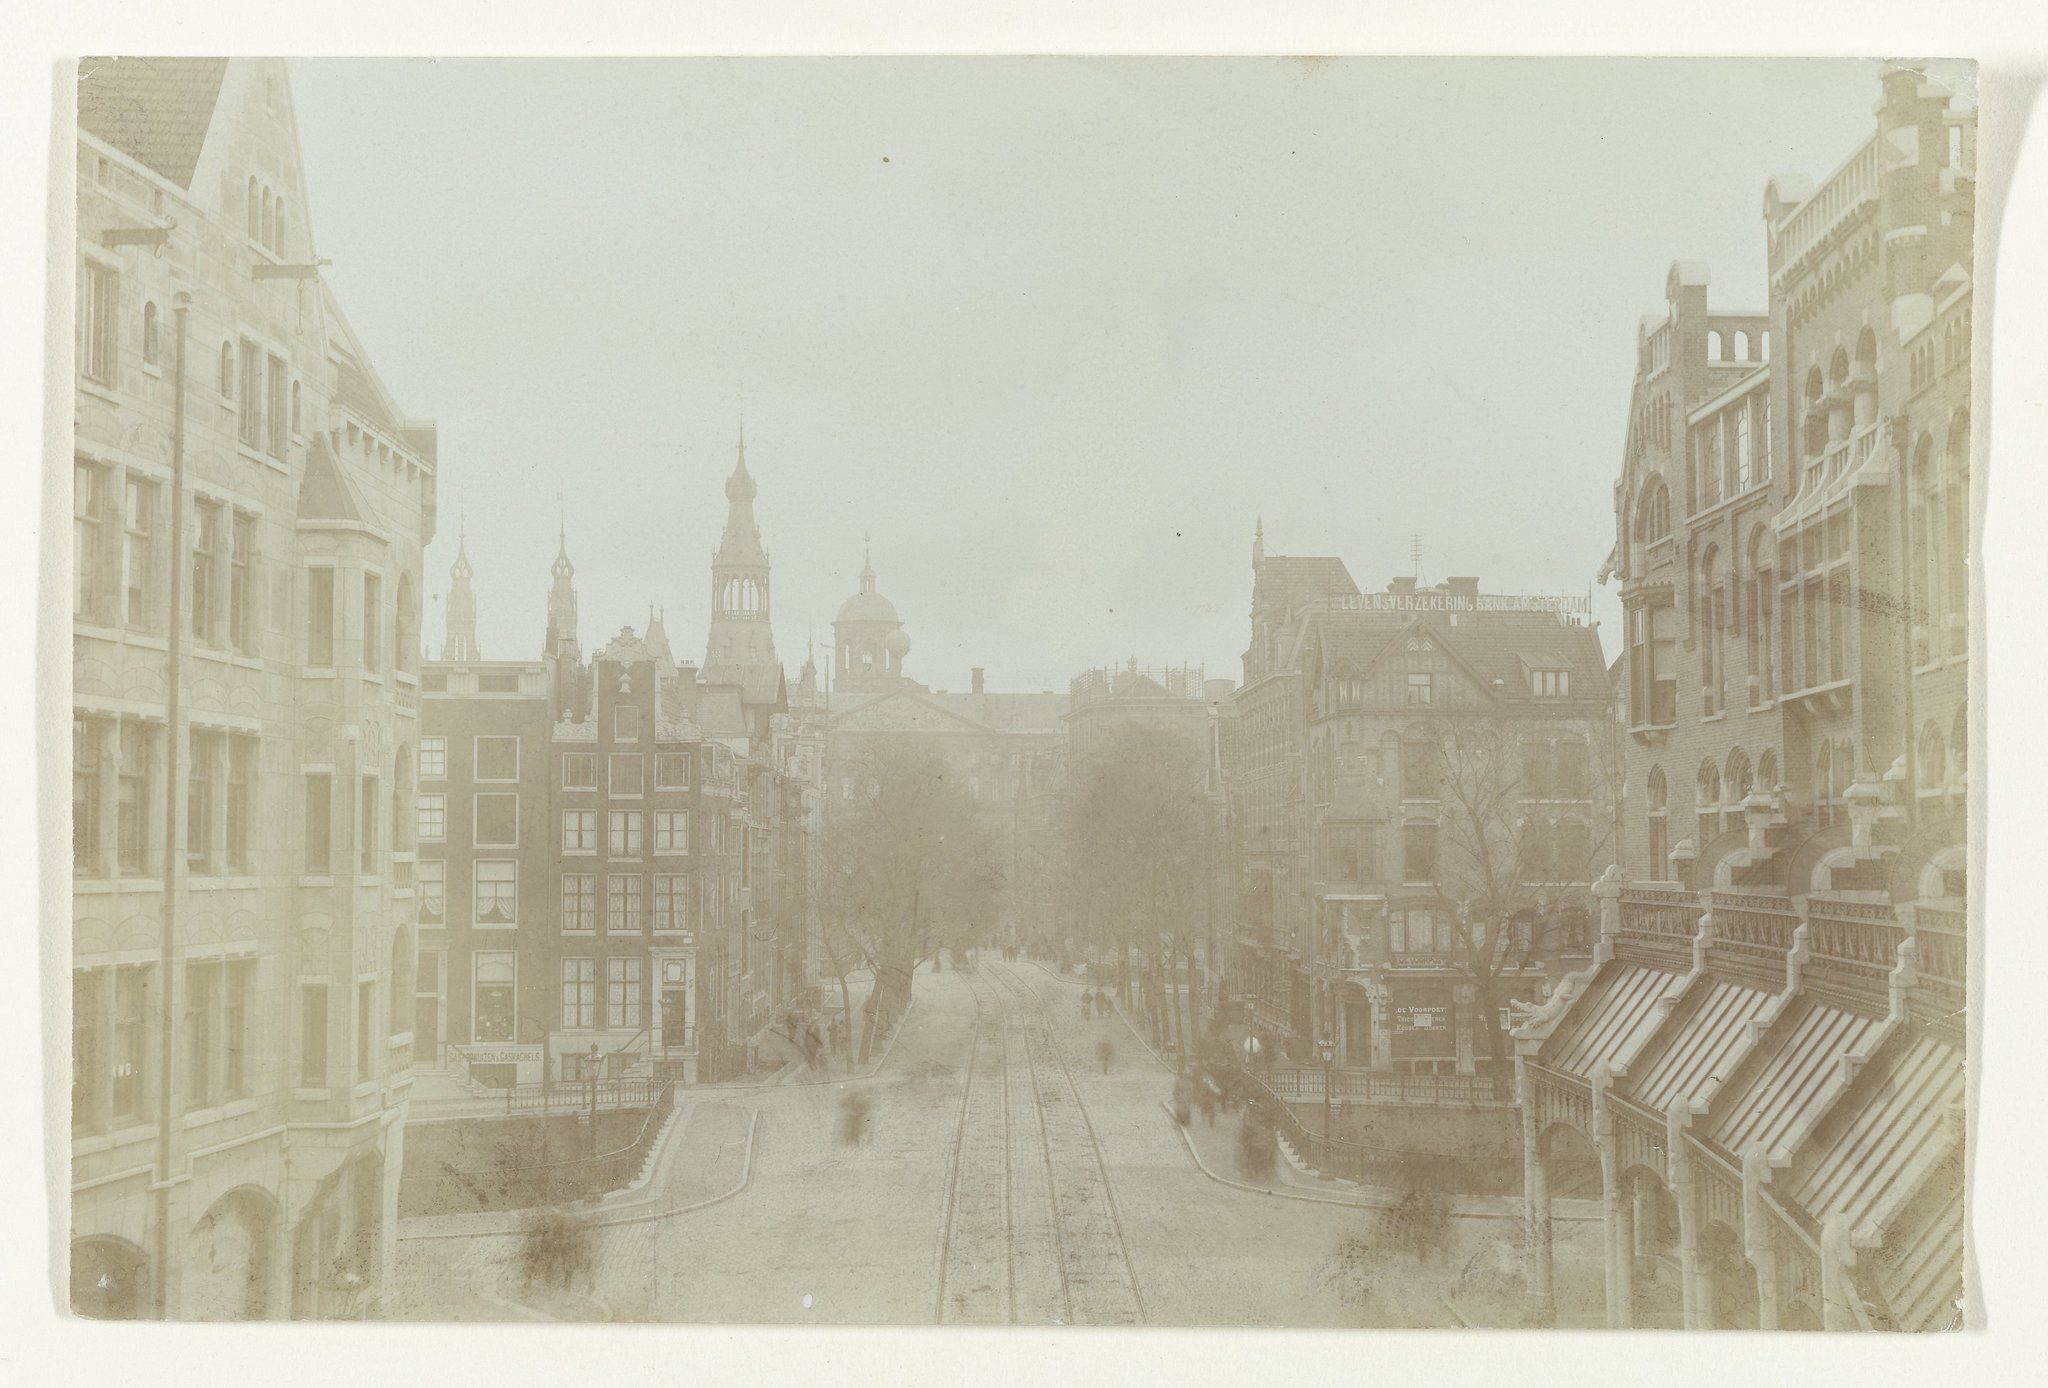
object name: photograph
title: Raadhuisstraat in Amsterdam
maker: Anonymous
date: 1898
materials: photographic support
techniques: gelatin silver print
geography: amsterdam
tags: street, amsterdam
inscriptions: annotation: ‘Raadhuisstraat // A'dam’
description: Gezicht op de Raadhuisstraat met aan het eind het Paleis op de Dam, genomen vanaf een hoog standpunt.